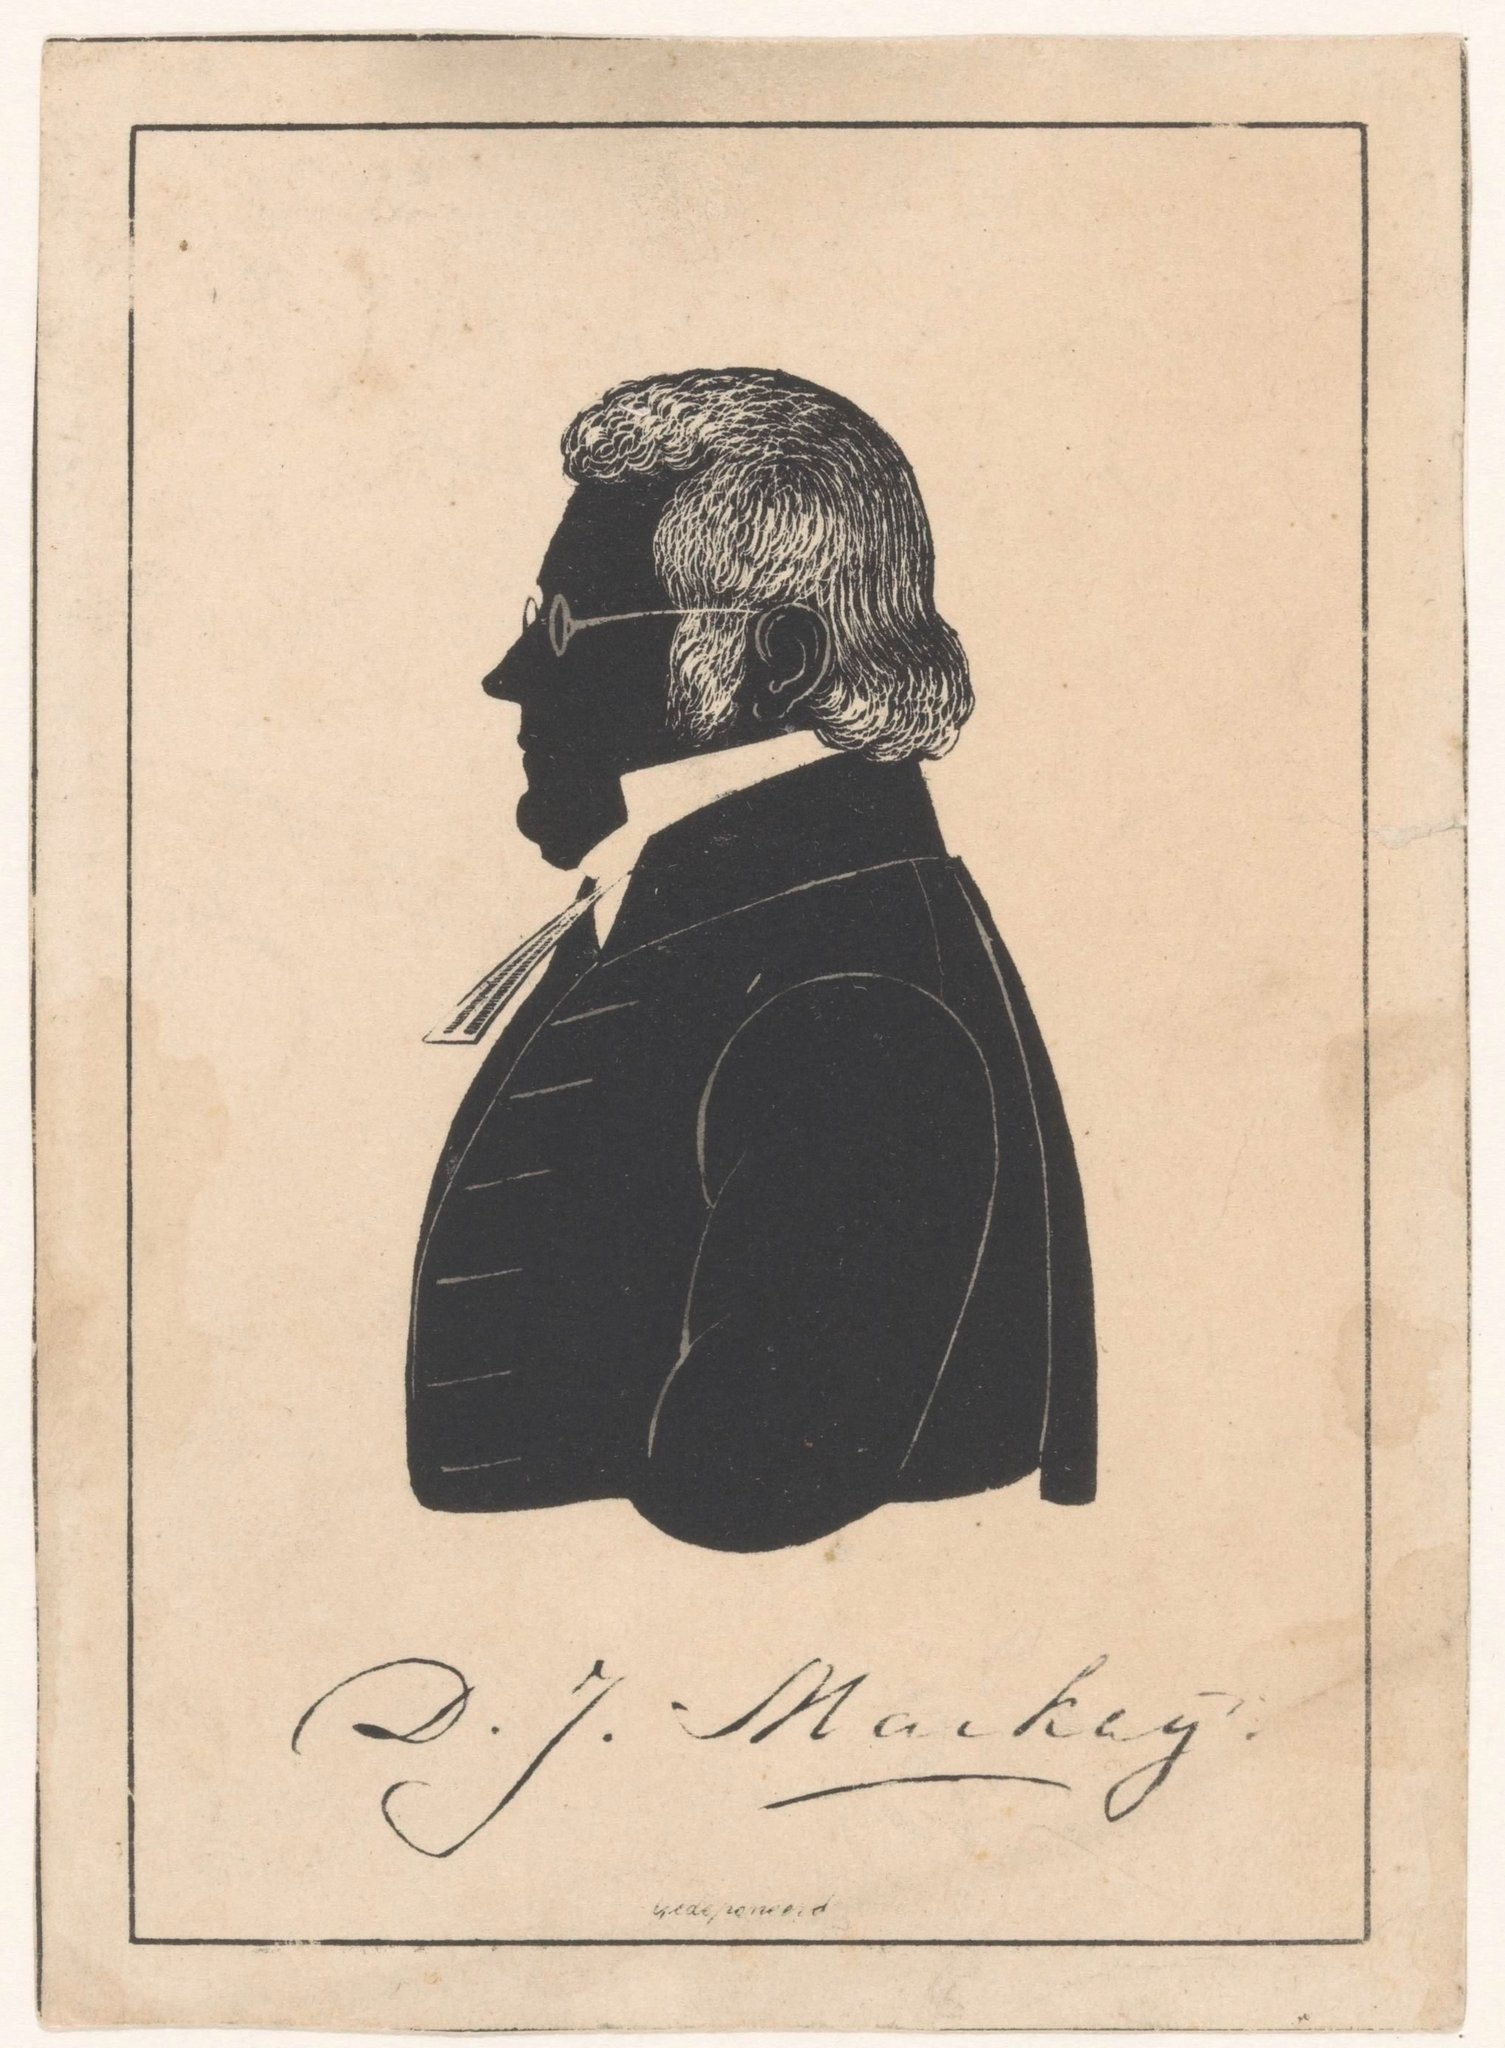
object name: print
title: Silhouetportret van Daniël Johannes Mackay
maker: pieter barbiers (iv)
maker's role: painter, print maker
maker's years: 1798-1848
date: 1809-1848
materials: paper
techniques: hand coloring, lithograph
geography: netherlands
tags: historical persons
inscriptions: collector's mark: Lugt 2228, : ‘Gedeponeerd.’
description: Onder het portret de signatuur van de geportretteerde.